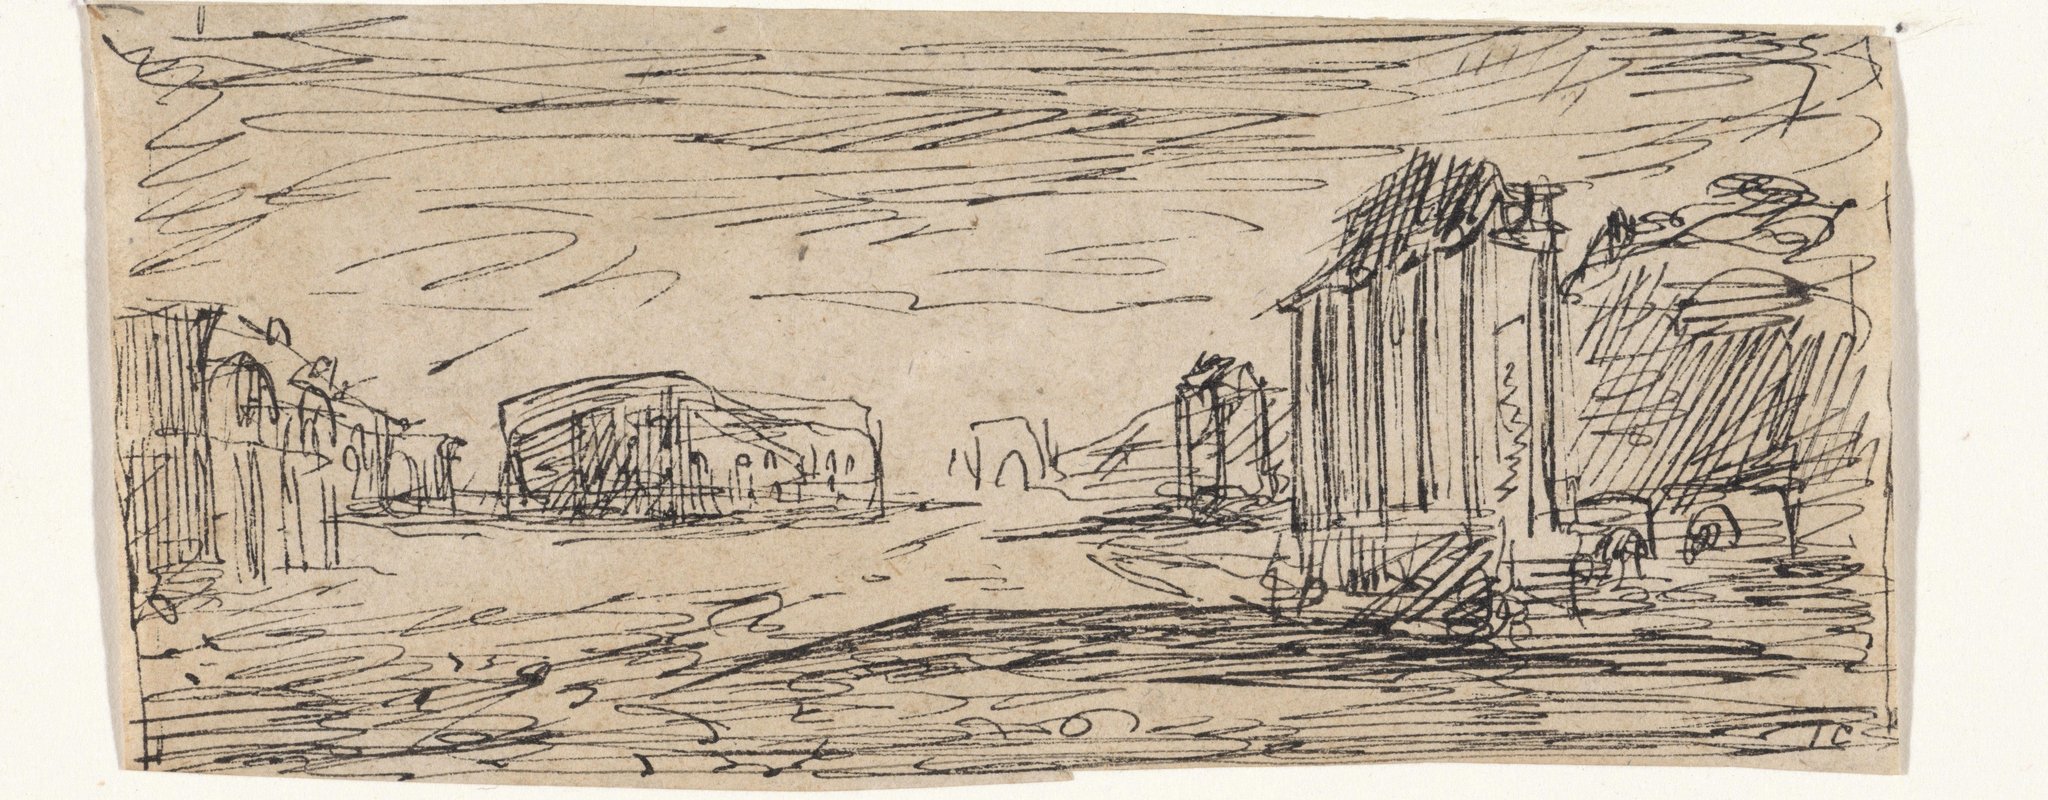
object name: drawing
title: Gezicht op het Coloseum, met op de voorgrond het Forum Romanum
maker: thomas cool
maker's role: draughtsman, painter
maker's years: 1851-1904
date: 1861-1904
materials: ink, paper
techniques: pen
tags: city-view, and landscape with man-made constructions, amphitheatre, rome